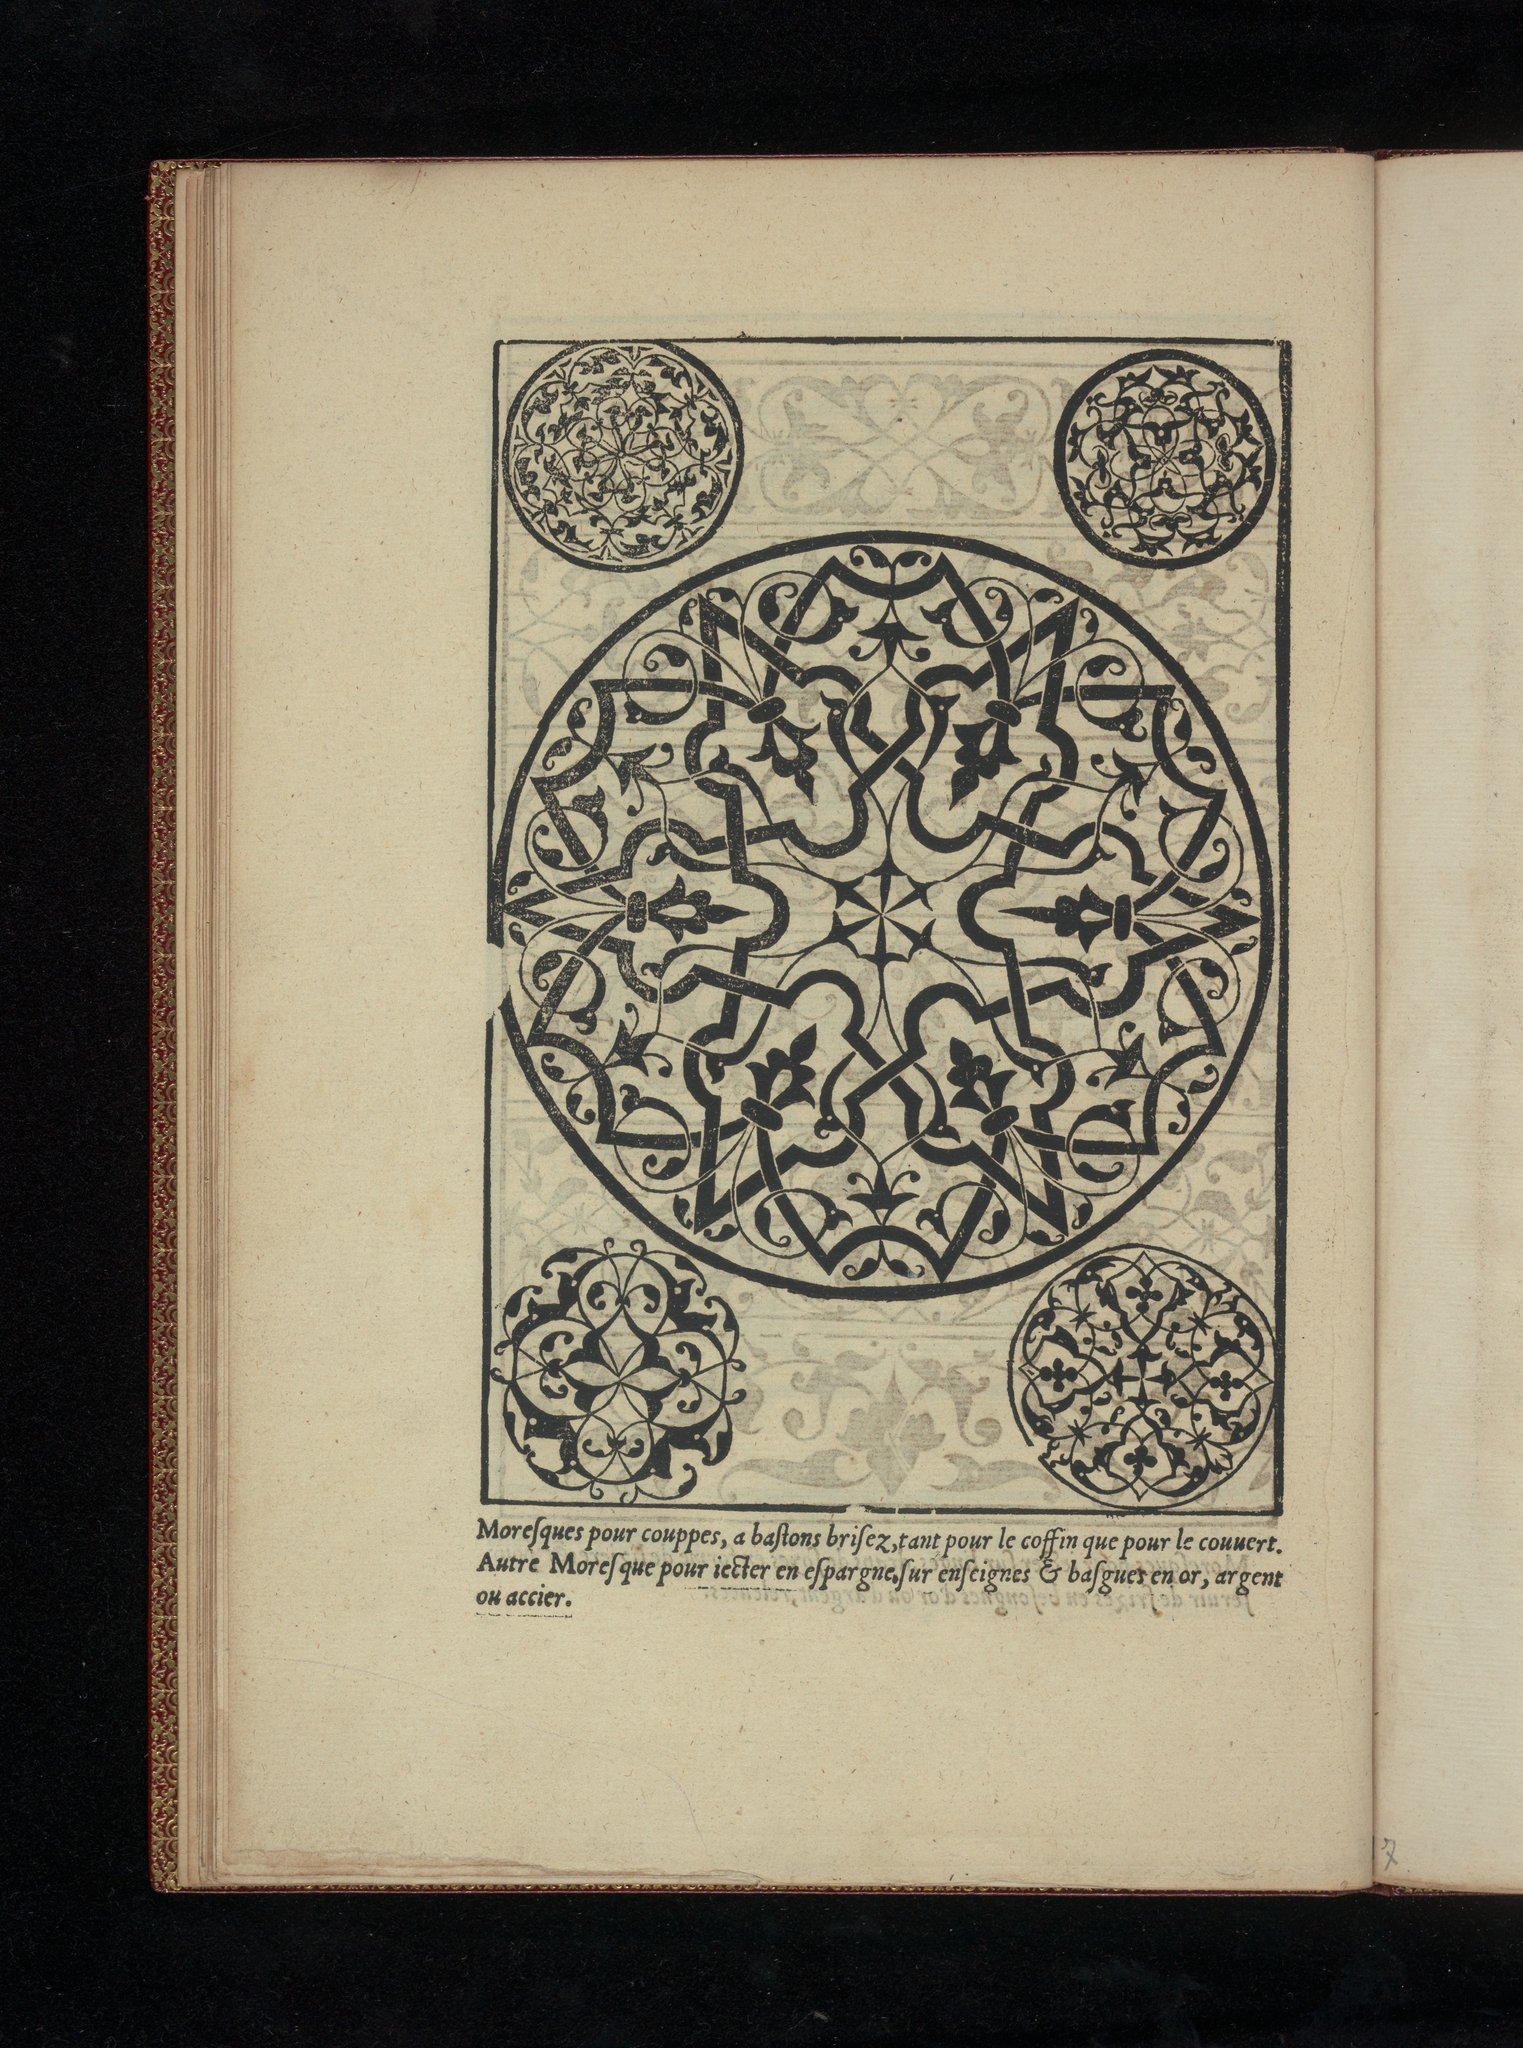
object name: book print ornament architecture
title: Livre de Moresques, page 9 (verso)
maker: francesco di pellegrino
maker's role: artist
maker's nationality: italian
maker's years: 1525-1552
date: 1546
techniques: woodcut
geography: france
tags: ornament